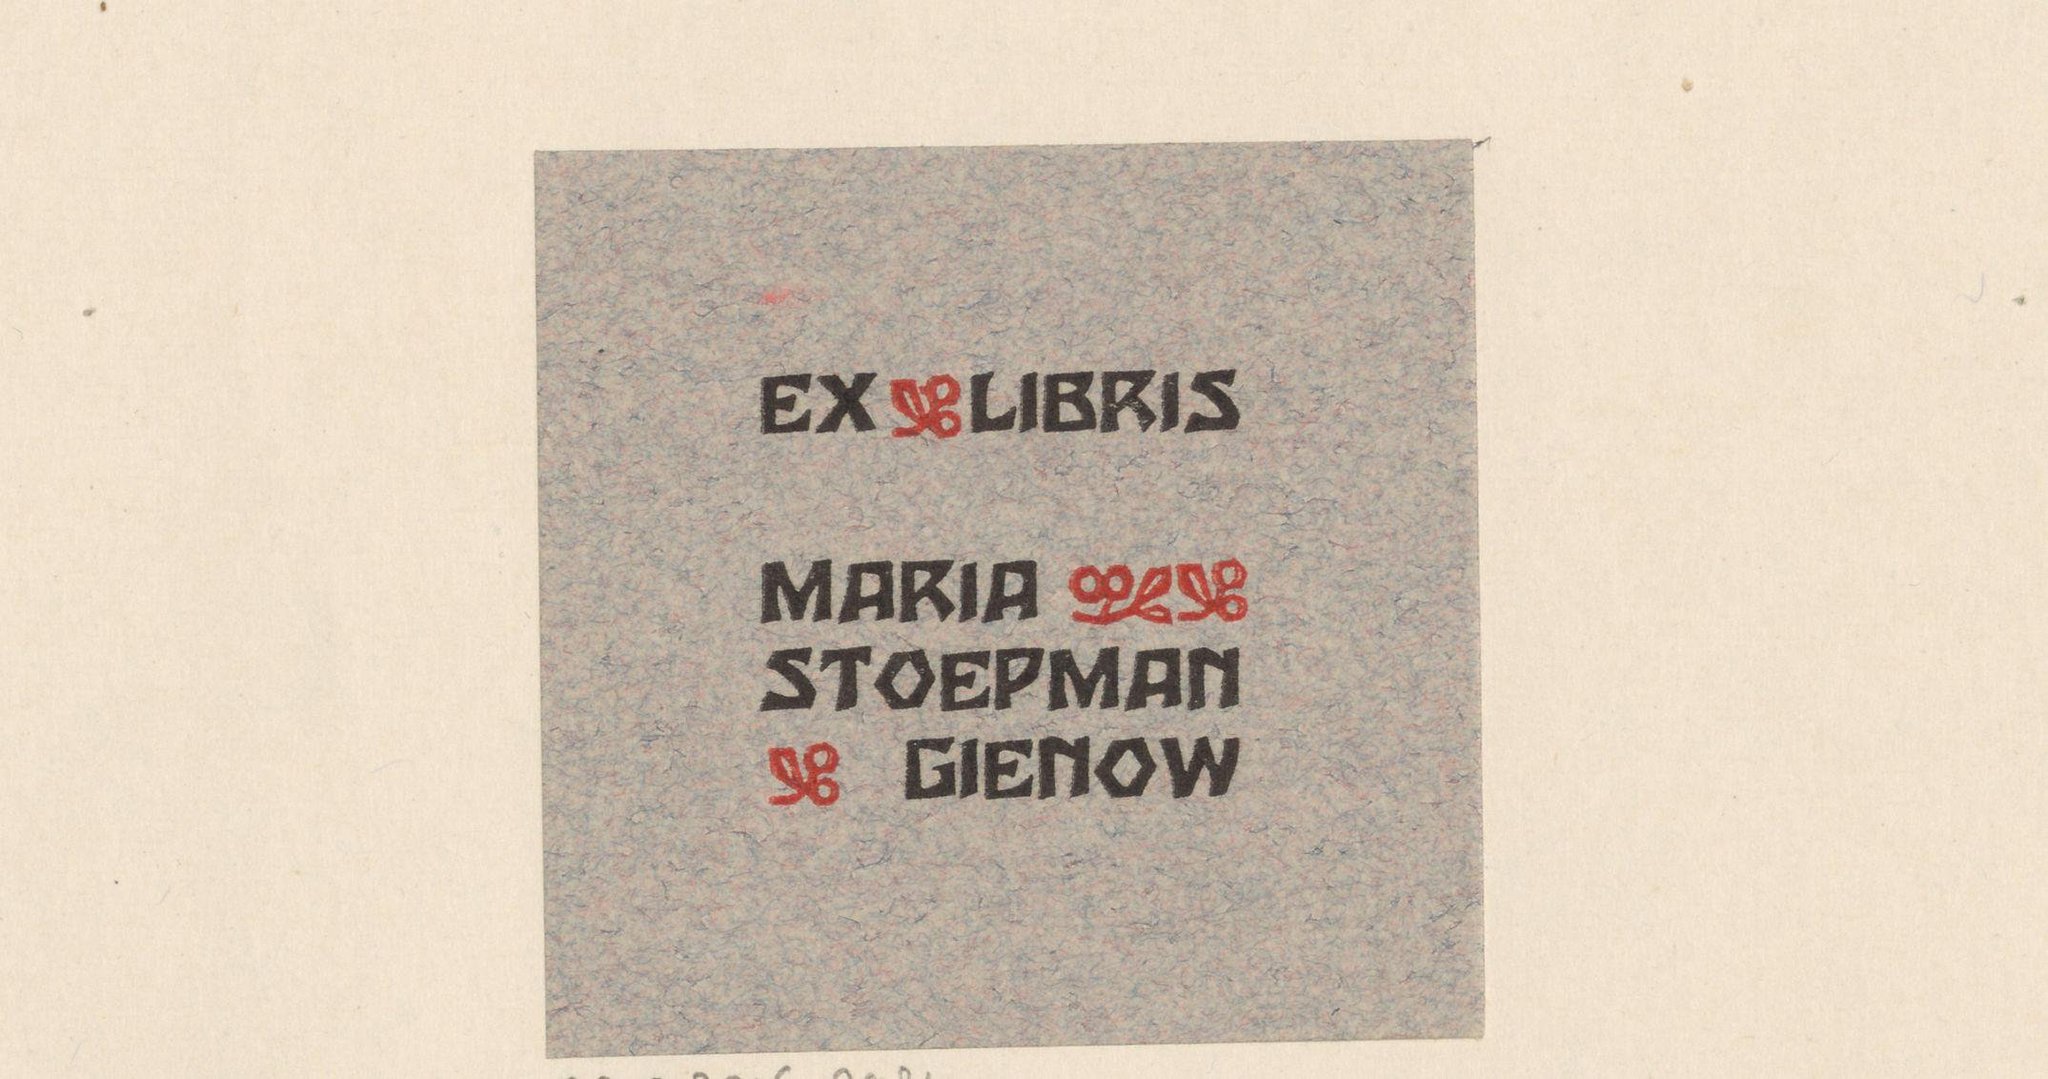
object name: bookplate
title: Ex libris van Maria Stoepman-Gienow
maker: g.e.f. stoepman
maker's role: print maker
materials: paper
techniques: printing block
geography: netherlands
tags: flowers ~ ornament - aa - stylized